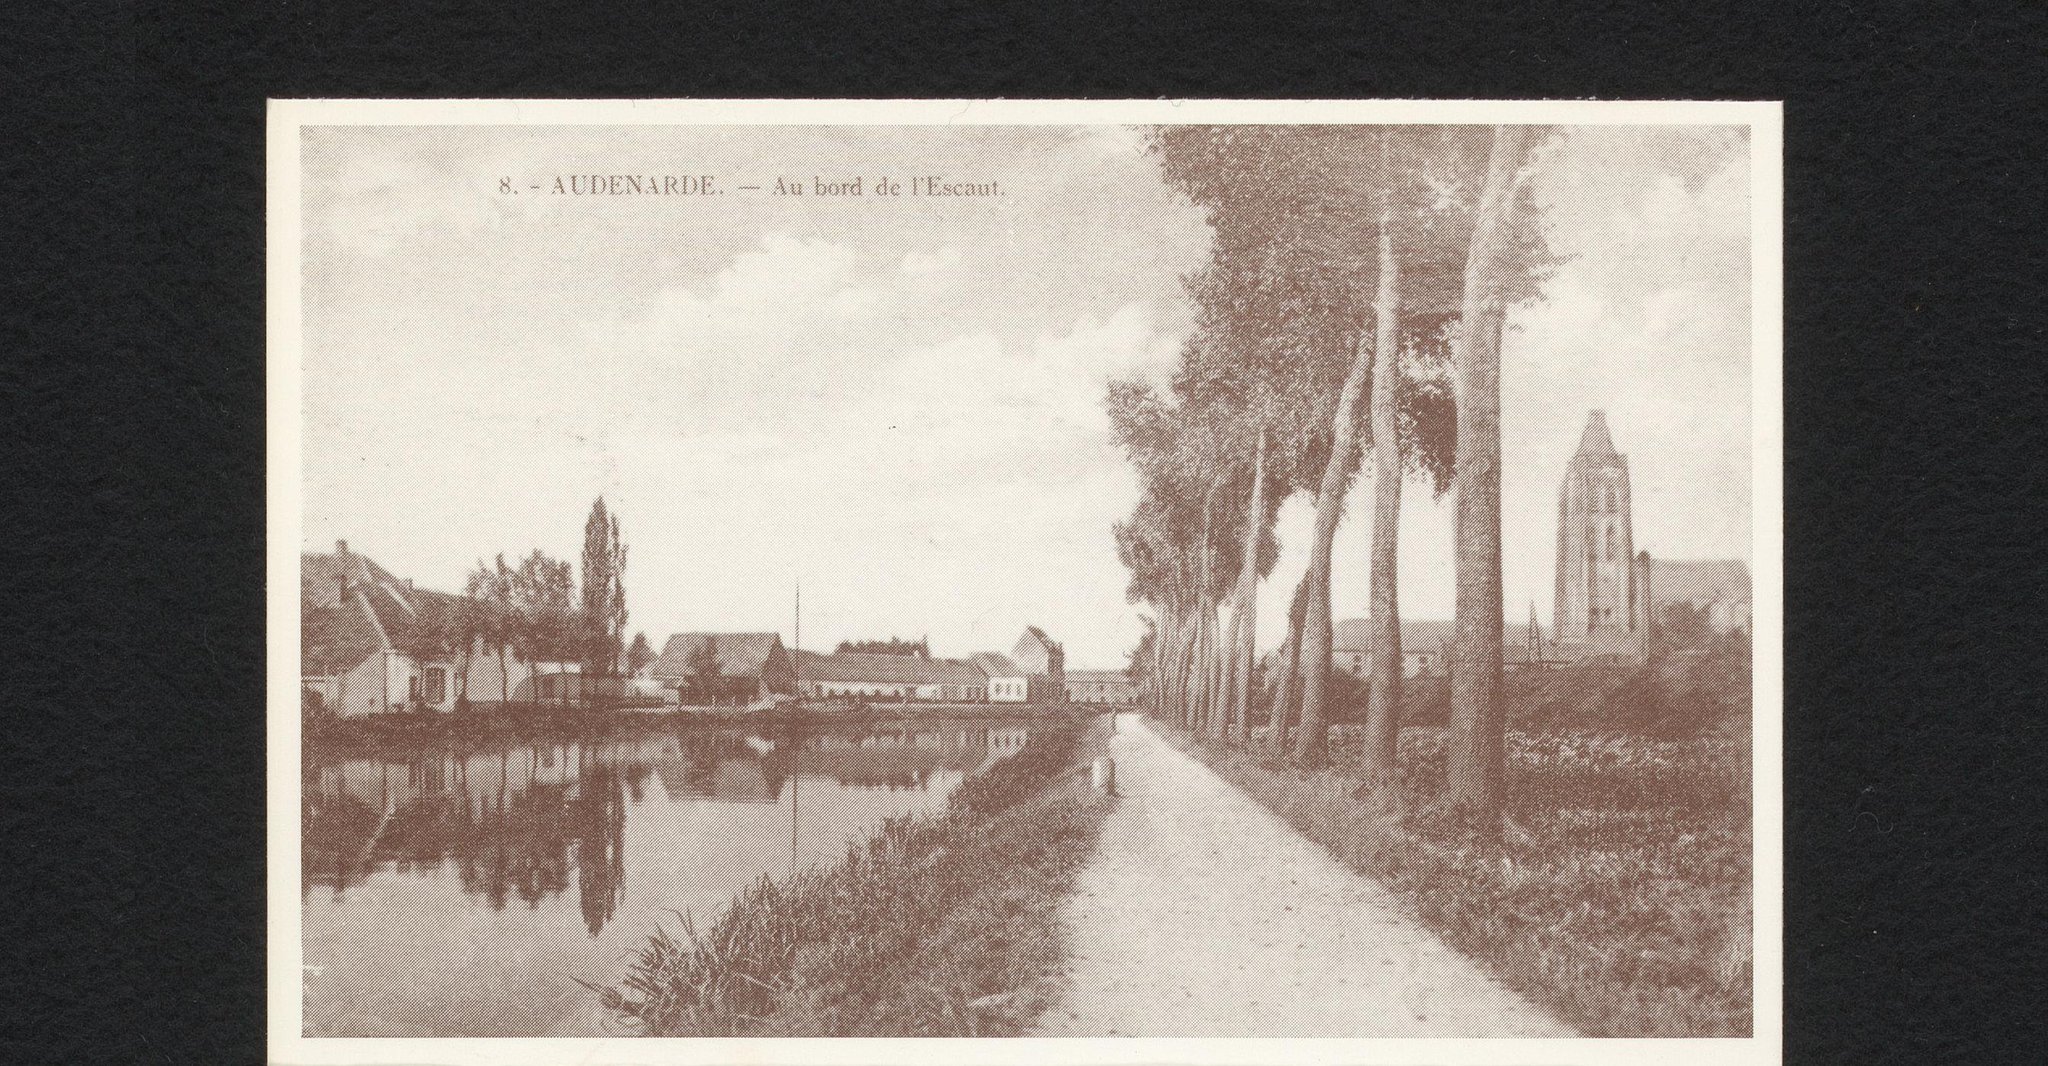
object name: ansichtkaart, prentbriefkaart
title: Audenaerde. Au bord de l'Escaut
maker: Anonymous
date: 1981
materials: cardboard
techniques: offset printed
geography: oudenaarde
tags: city-view, and landscape with man-made constructions, river, church (exterior)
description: Deze prentbriefkaart is een reproductie van een oudere prentbriefkaart.